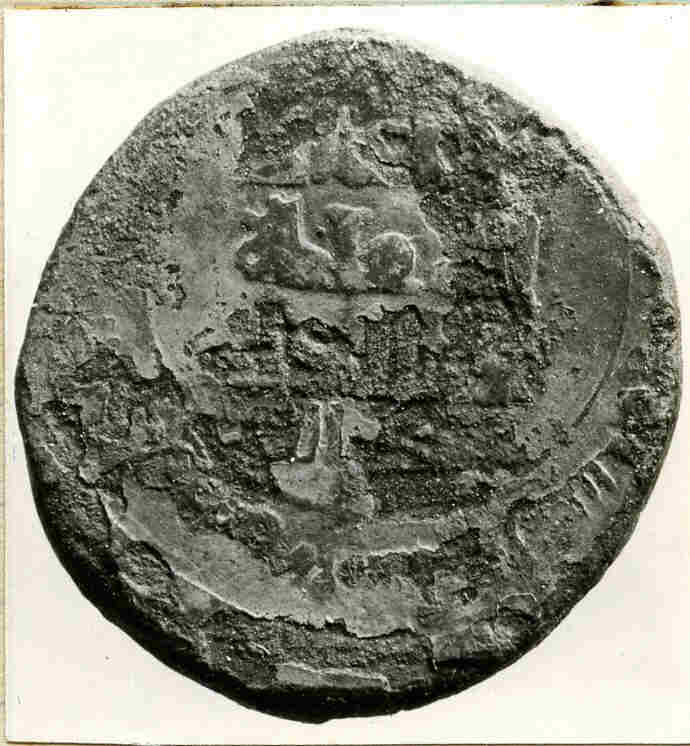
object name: coin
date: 1101-1200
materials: copper, silver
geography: iran